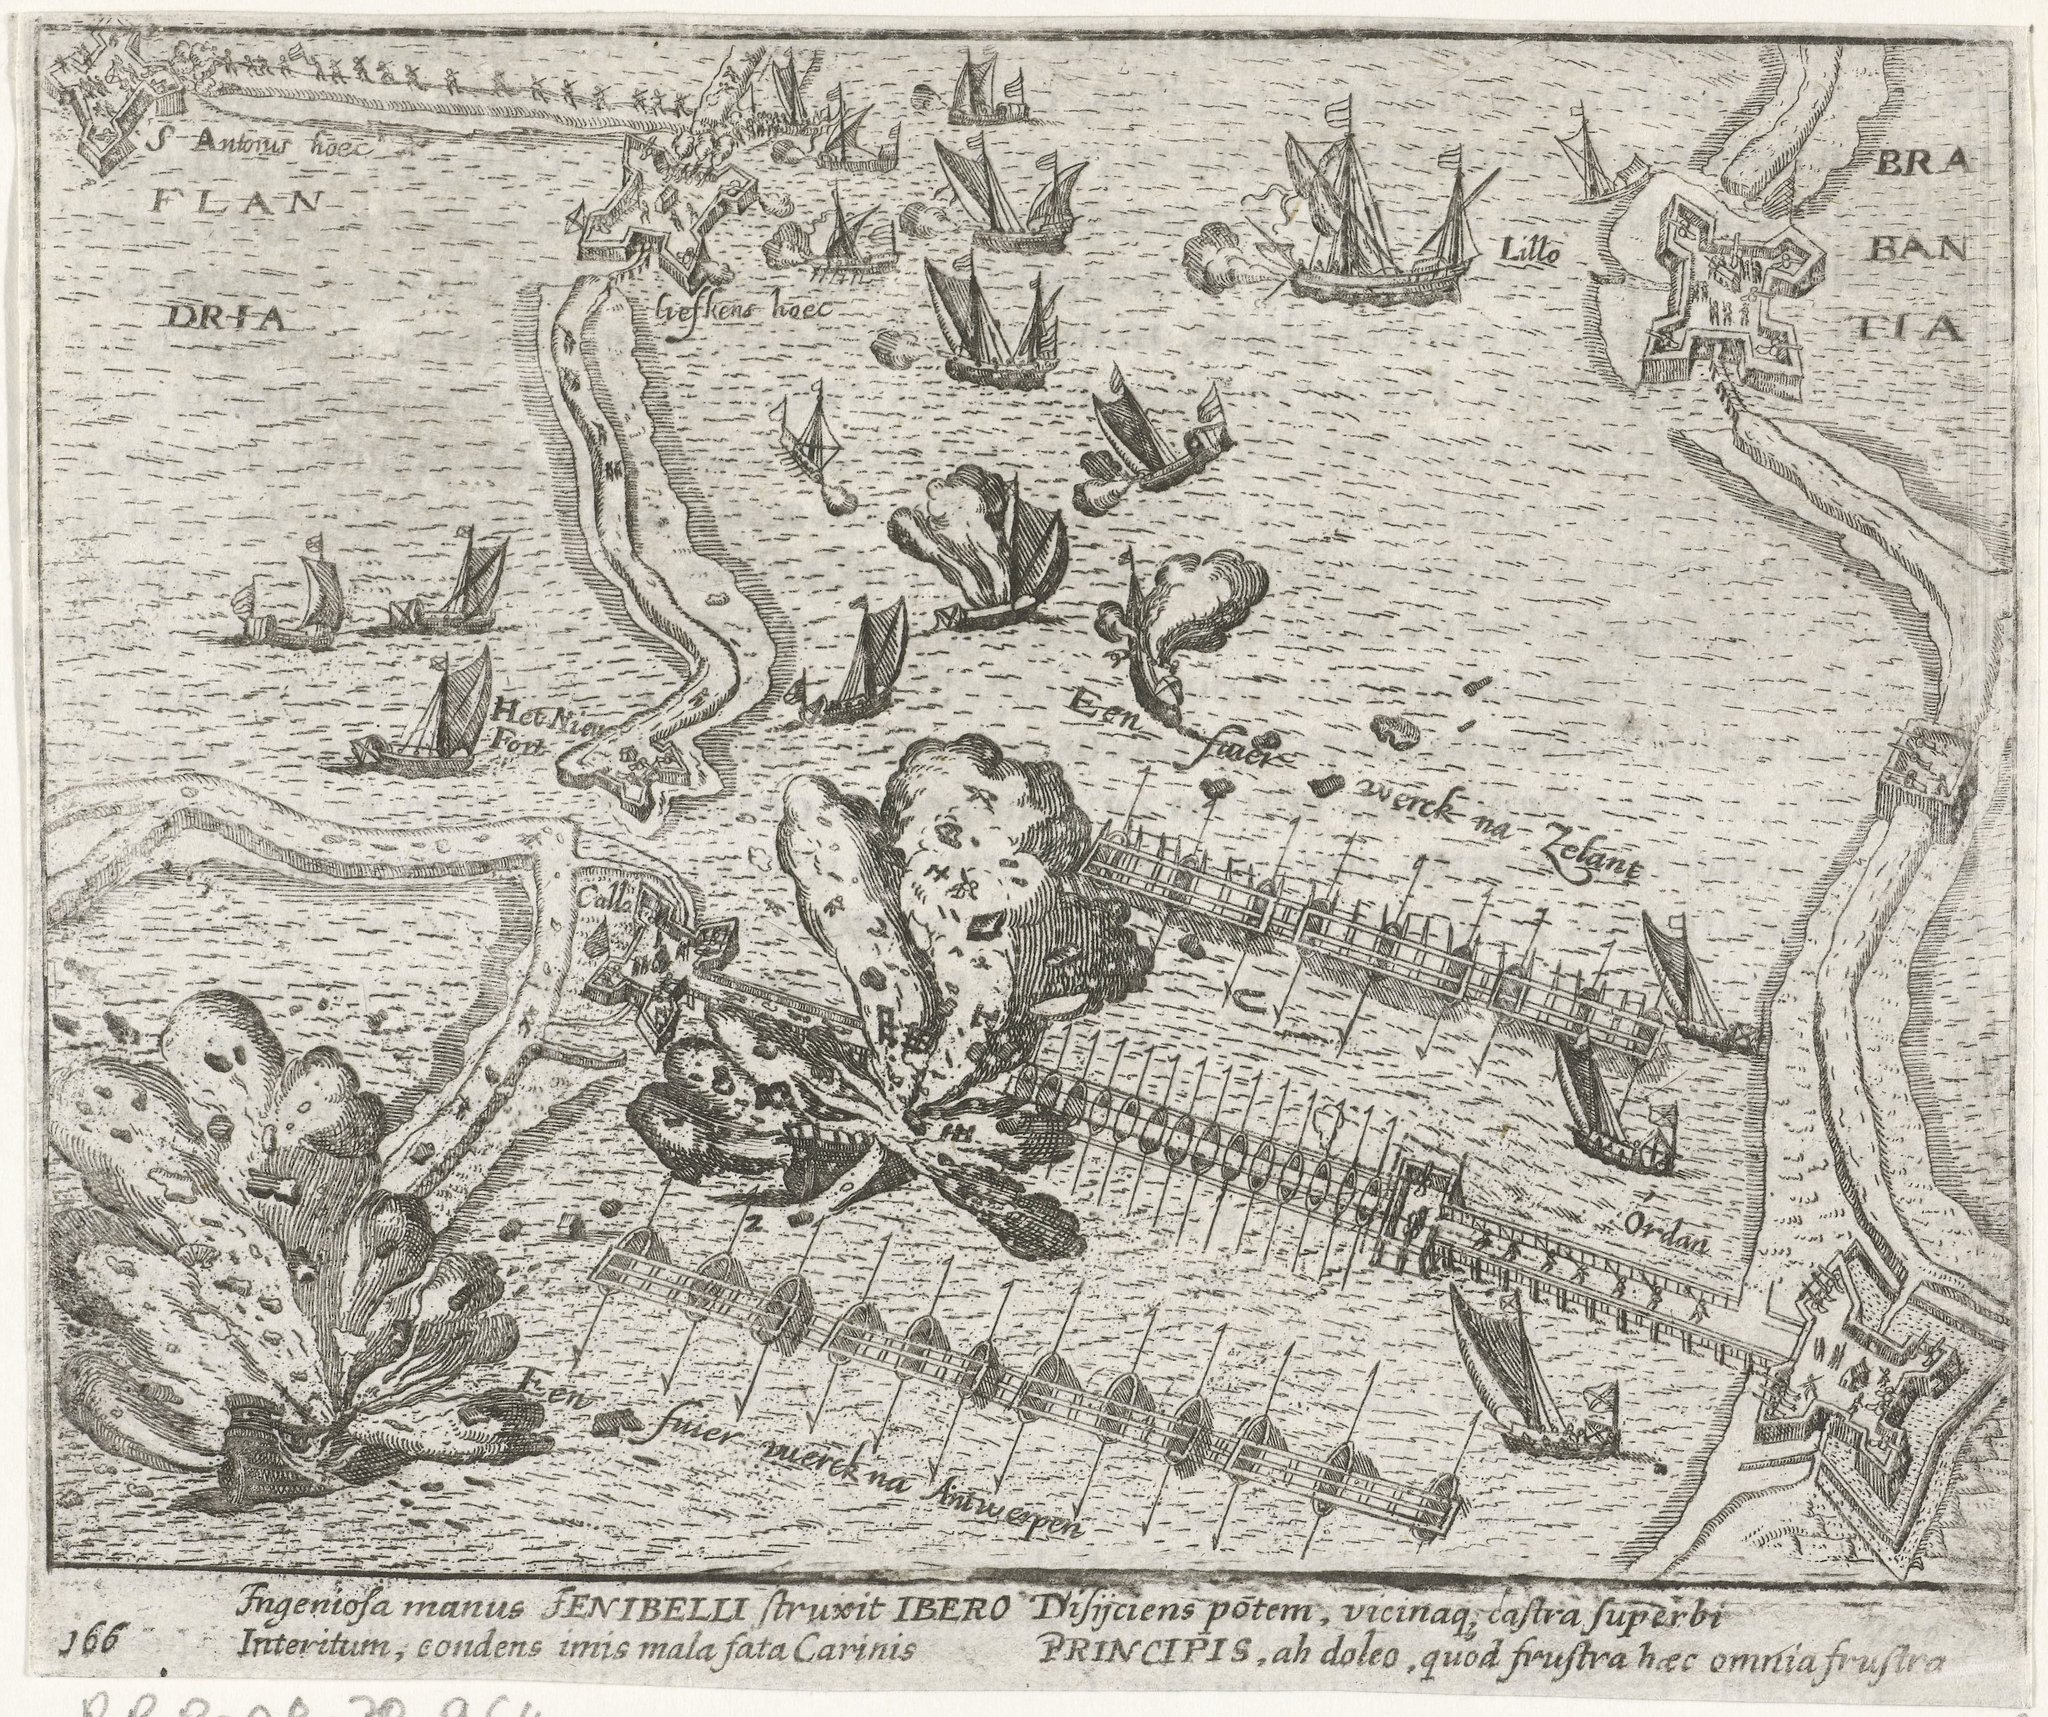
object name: history print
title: Beleg en inname van Antwerpen in 1585: Schipbrug van de hertog van Parma over de Schelde opgeblazen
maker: Anonymous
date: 1613-1615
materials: paper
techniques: etching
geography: northern netherlands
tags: rome, alessandro farnese (landvoogd van de nederlanden en hertog van parma en piacenza), pontoon bridge, antwerp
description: Schipbrug van de hertog van Parma over de Schelde opgeblazen, 5 april 1585. Onderdeel van een groep voorstellingen van het beleg en inname van Antwerpen door de hertog van Parma, juli 1584 tot 17 augustus 1585. Met onderschrift van 4 regels in het Latijn. Genummerd 166. Bedrukt op achterzijde met tekst in het Latijn.